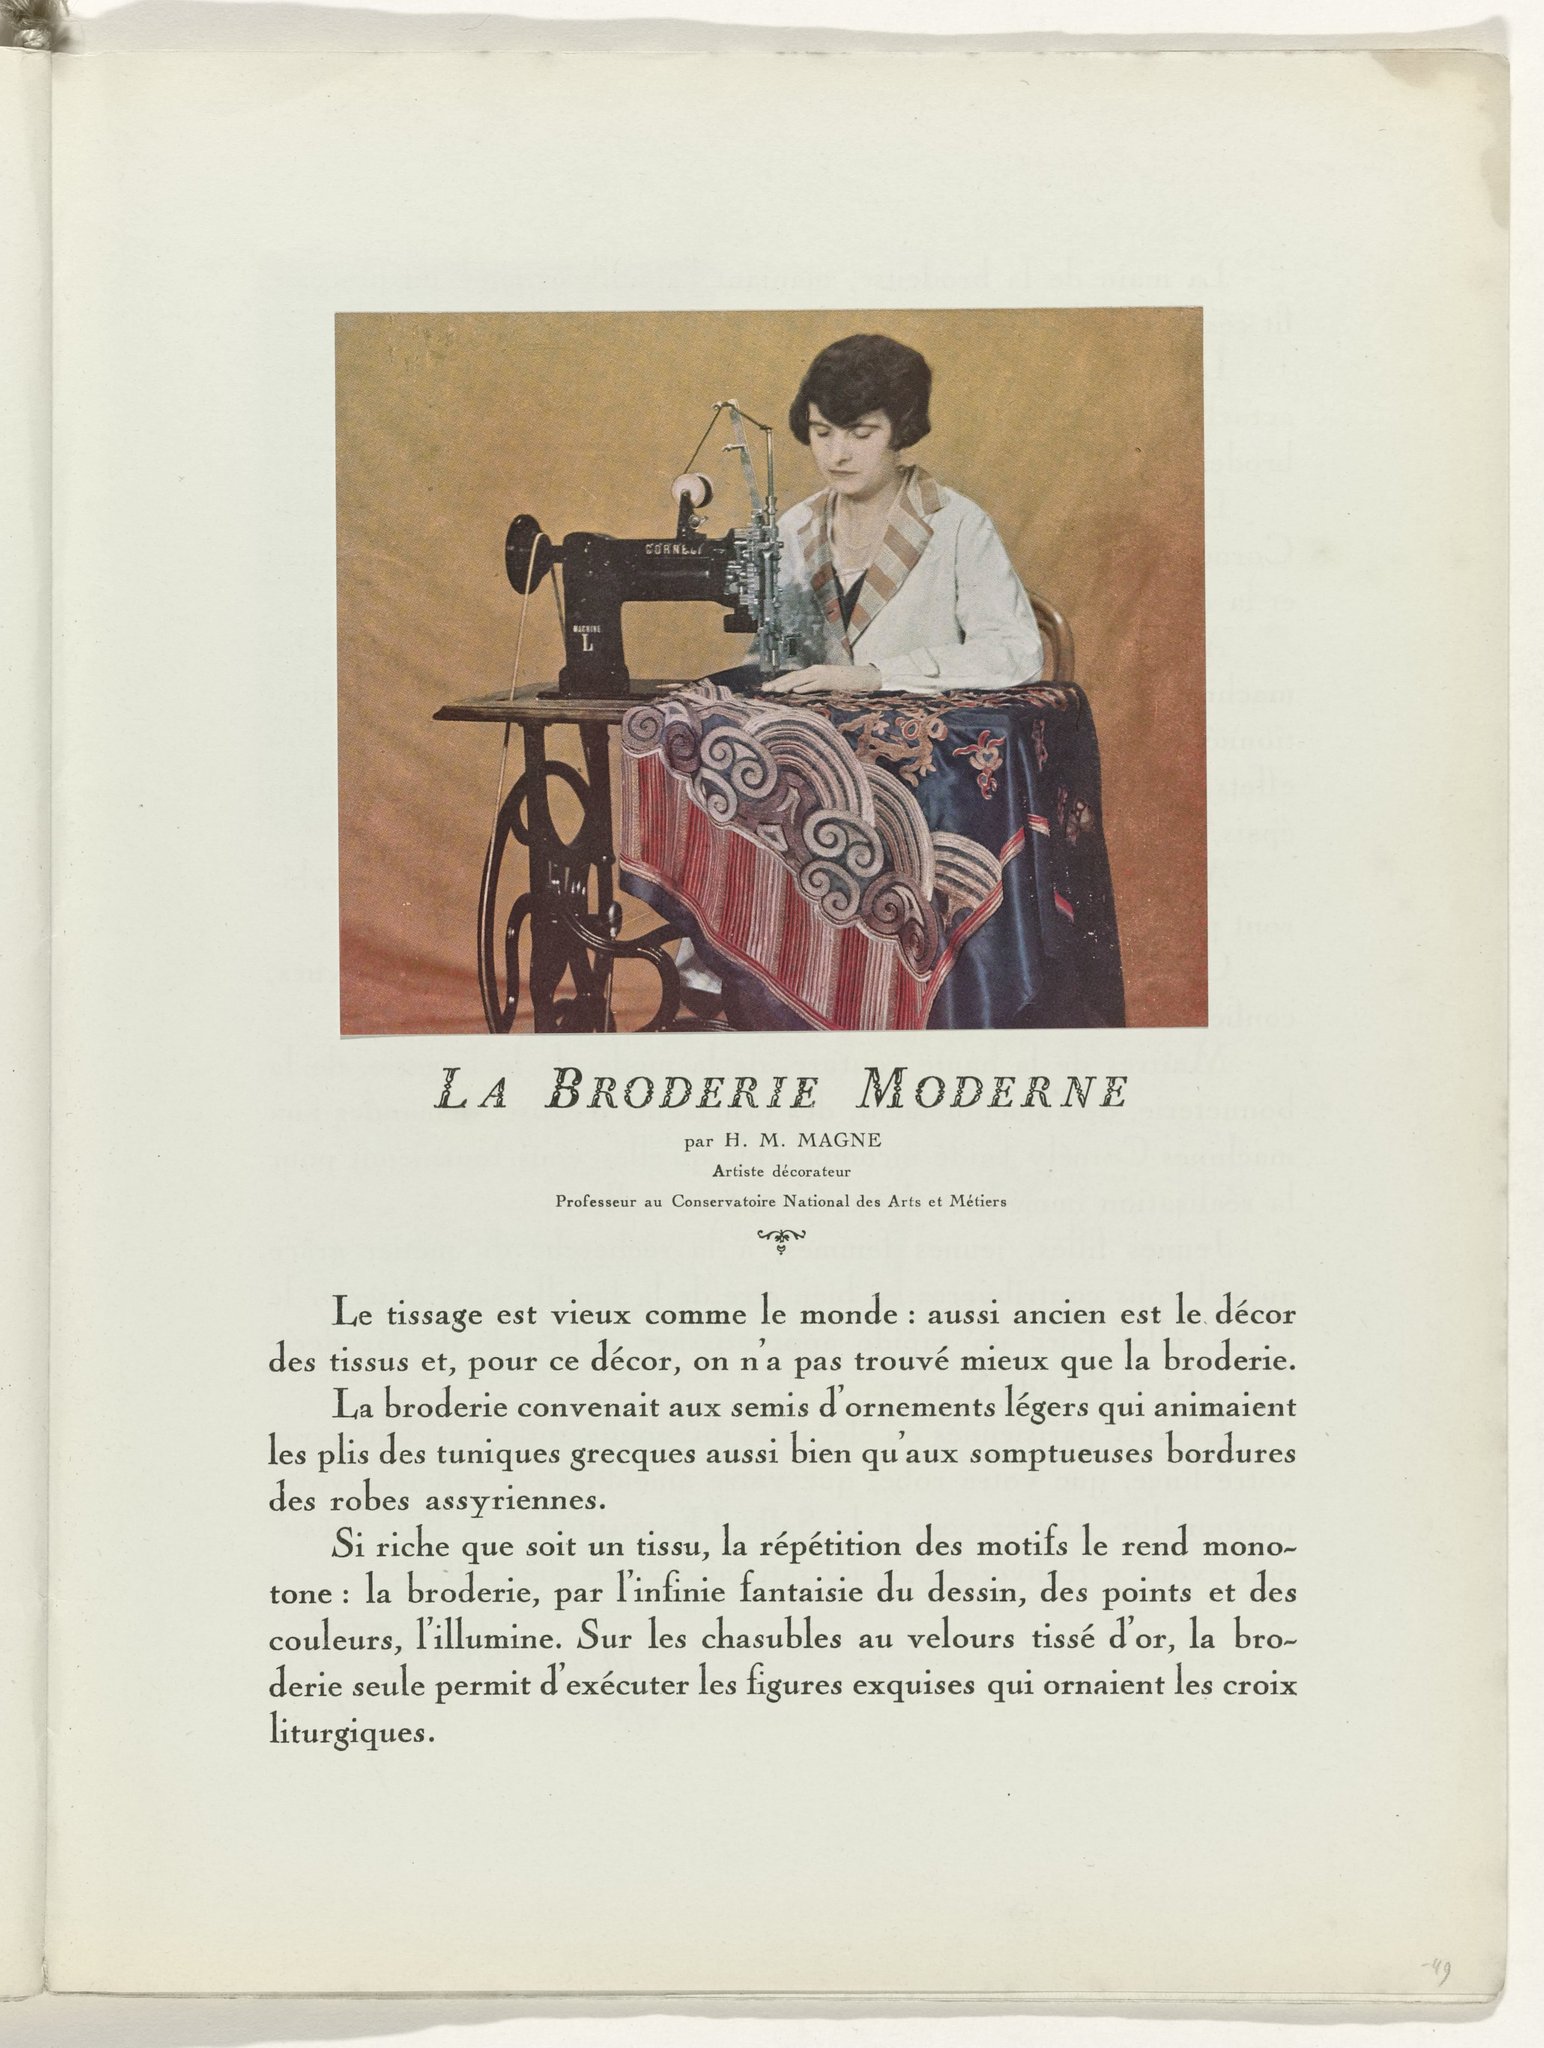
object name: fashion print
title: Art - Goût - Beauté, Feuillets de l' élégance féminine, Noël 1928, No. 100, 9e Année, p. 49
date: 1928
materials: paper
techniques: printing, lithograph, photography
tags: sewing machine, fashion plates, embroidery (ornamentation)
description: Tekst 'La Broderie Moderne' met een afbeelding van een vrouw achter een naaimachine. Pagina uit het modetijdschrift Art-Goût-Beauté (1920-1933).